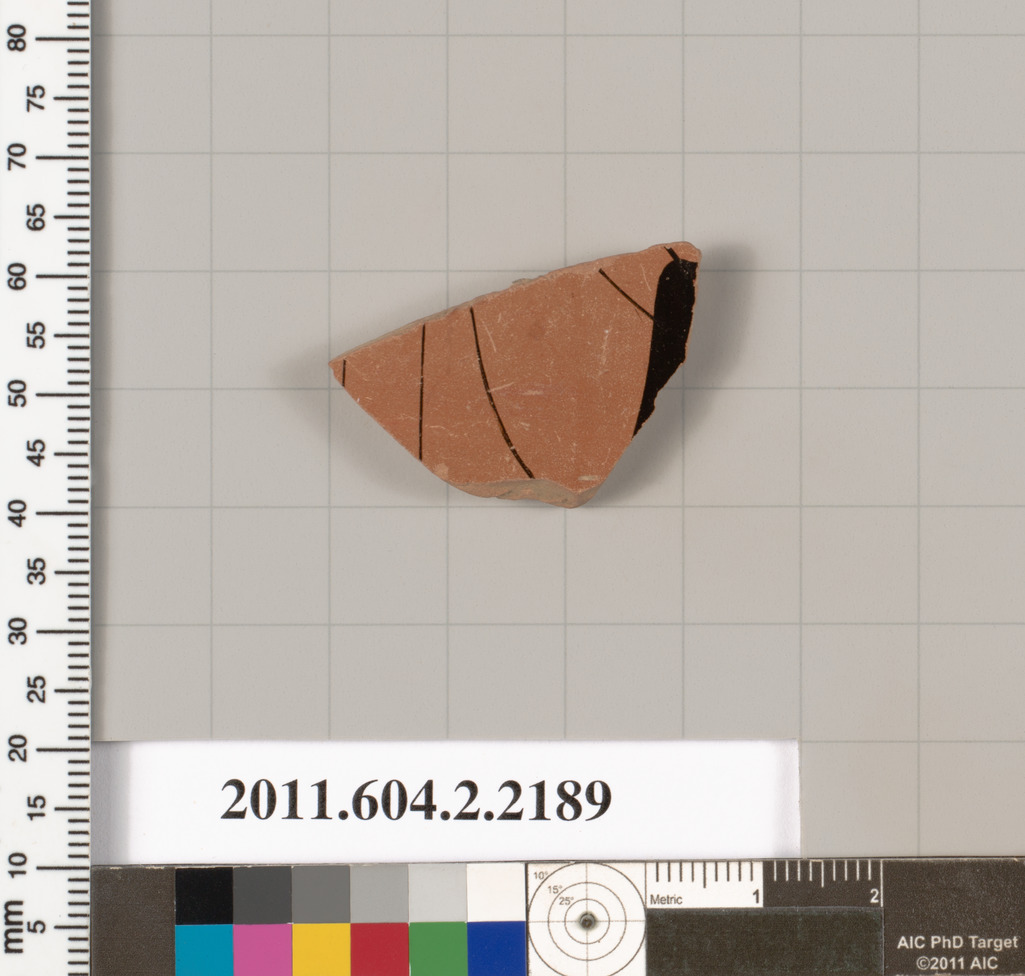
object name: pot fragment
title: Terracotta fragment of a pot; unglazed on the inside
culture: greek, attic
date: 460-440 BCE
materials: terracotta